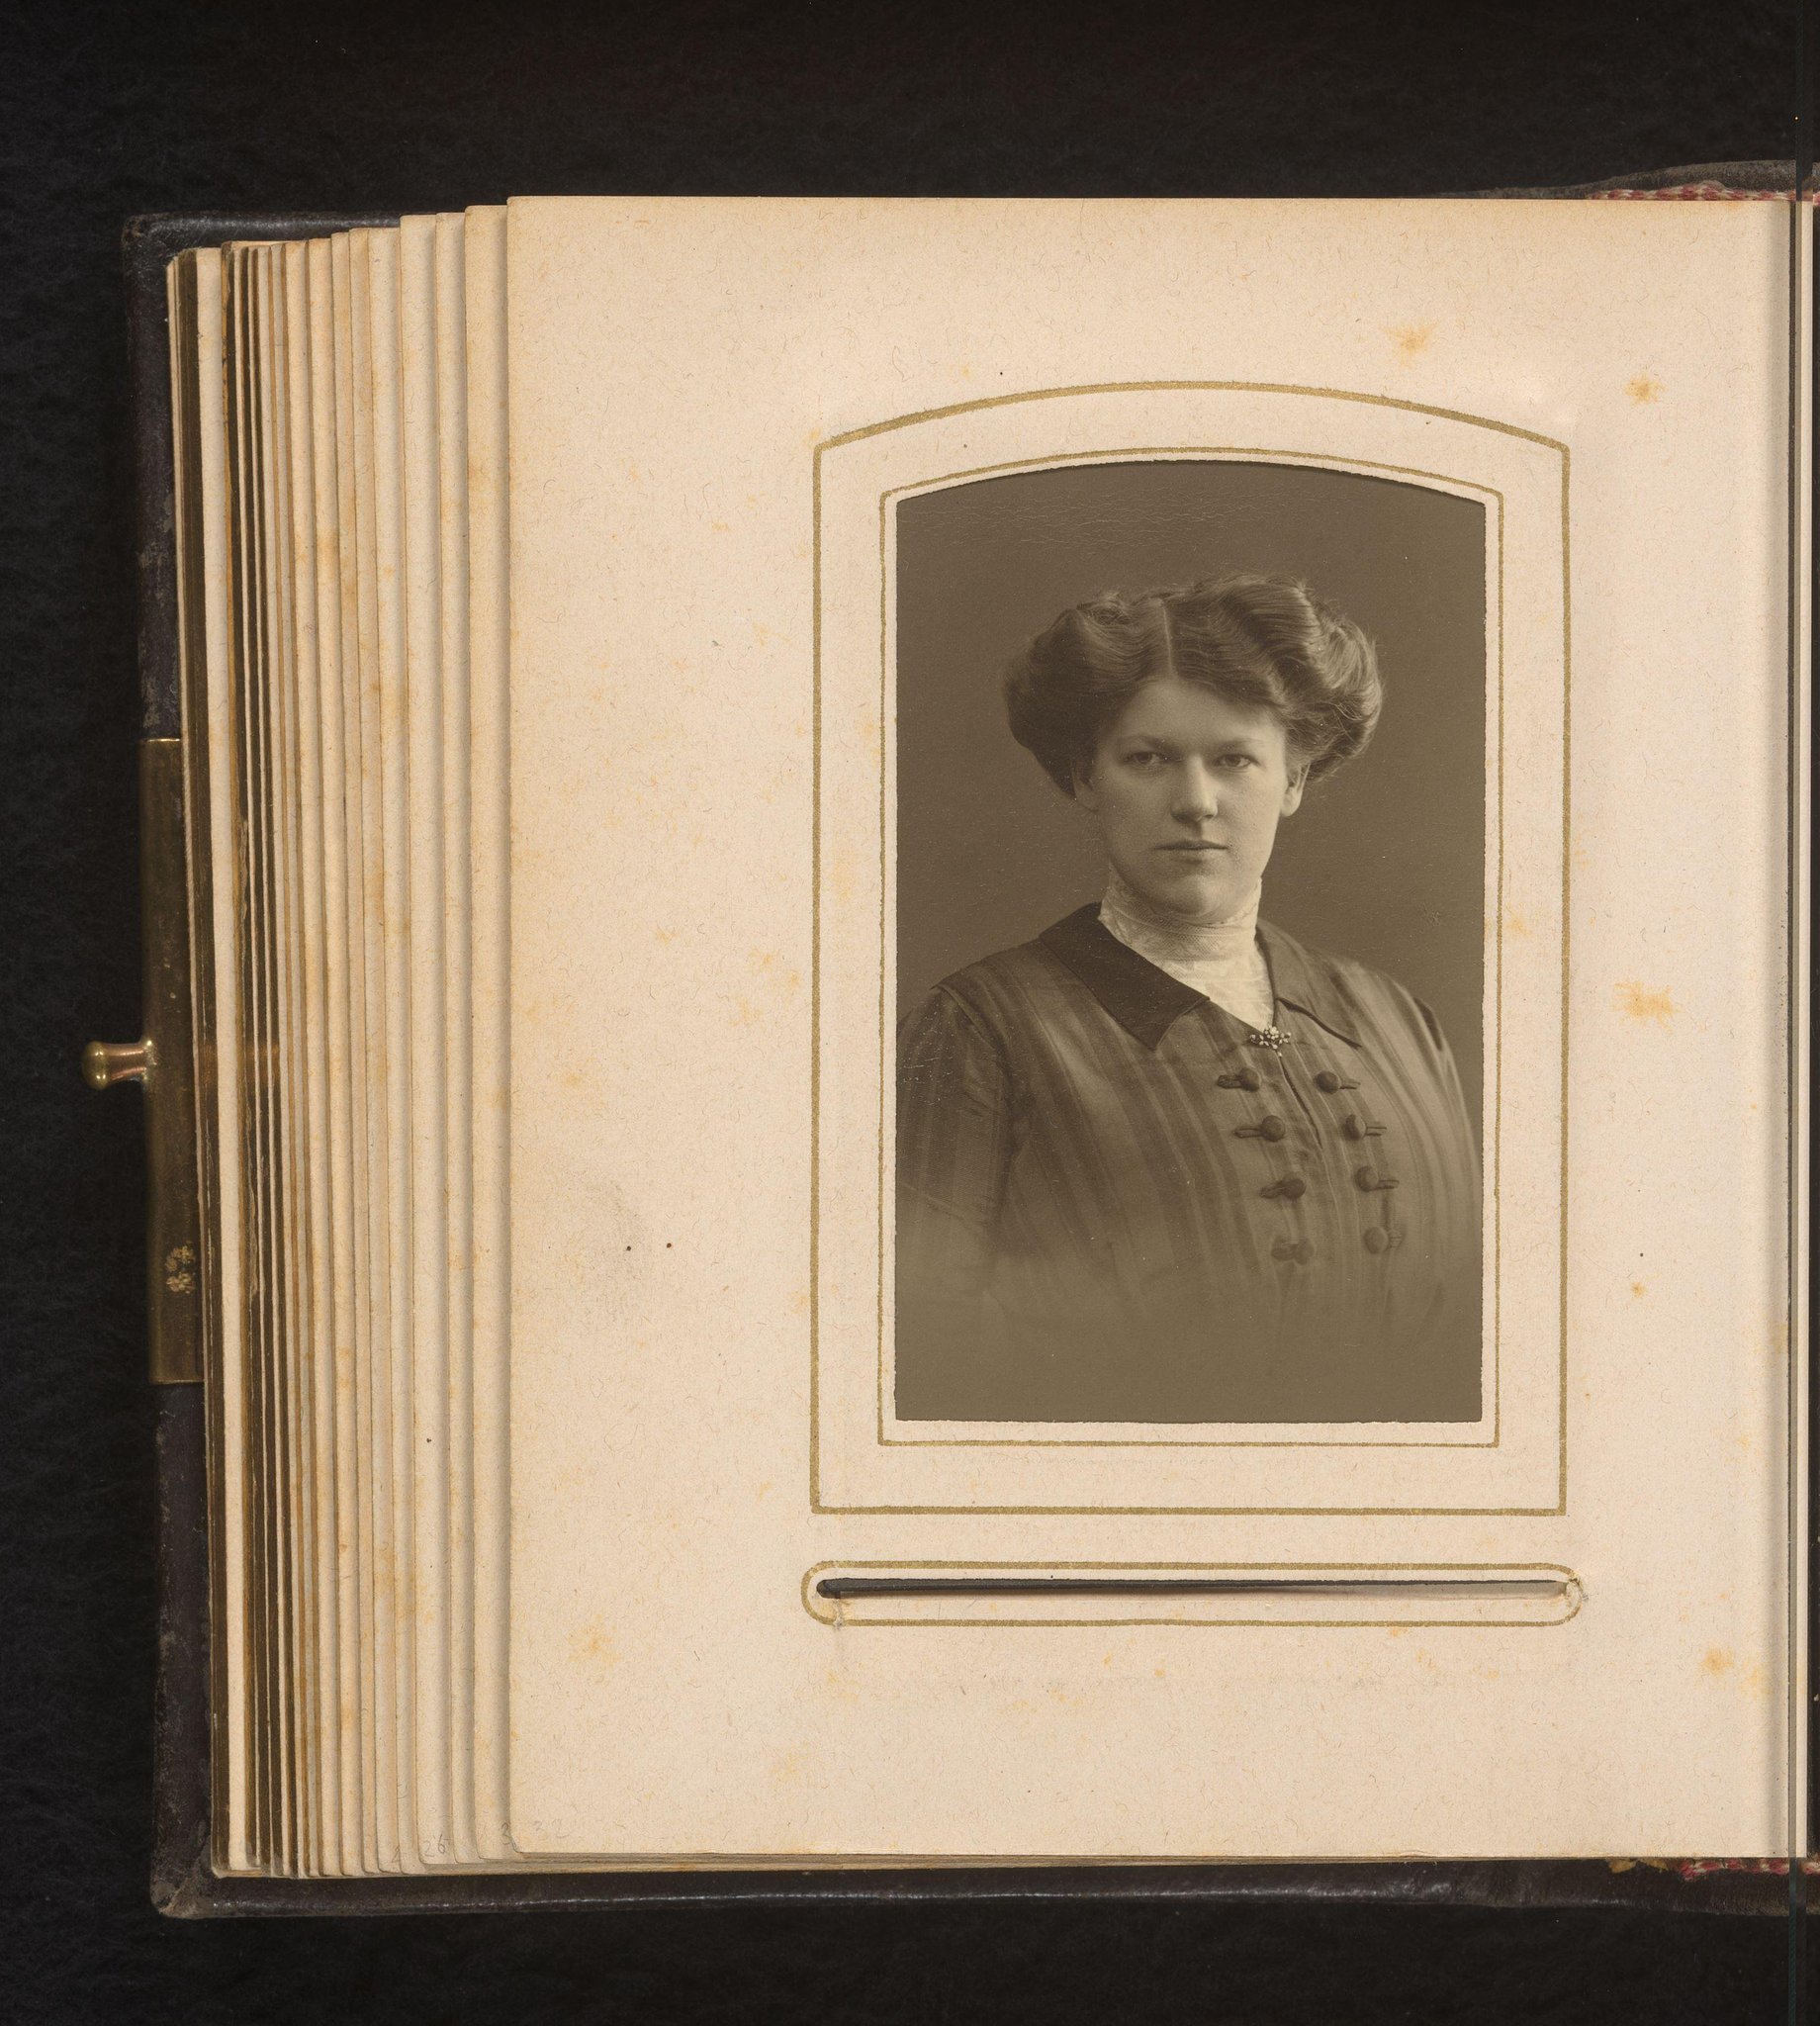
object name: carte de visite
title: Portret van een vrouw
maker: a. schlegel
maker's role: fotograaf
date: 1870-1910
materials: cardboard, photographic support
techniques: collodion silver print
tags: adult woman, historical persons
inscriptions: inscription: ‘A. Schlegel & Co./ Atelier für künstlerische/ portraits/ Bremen (...)’